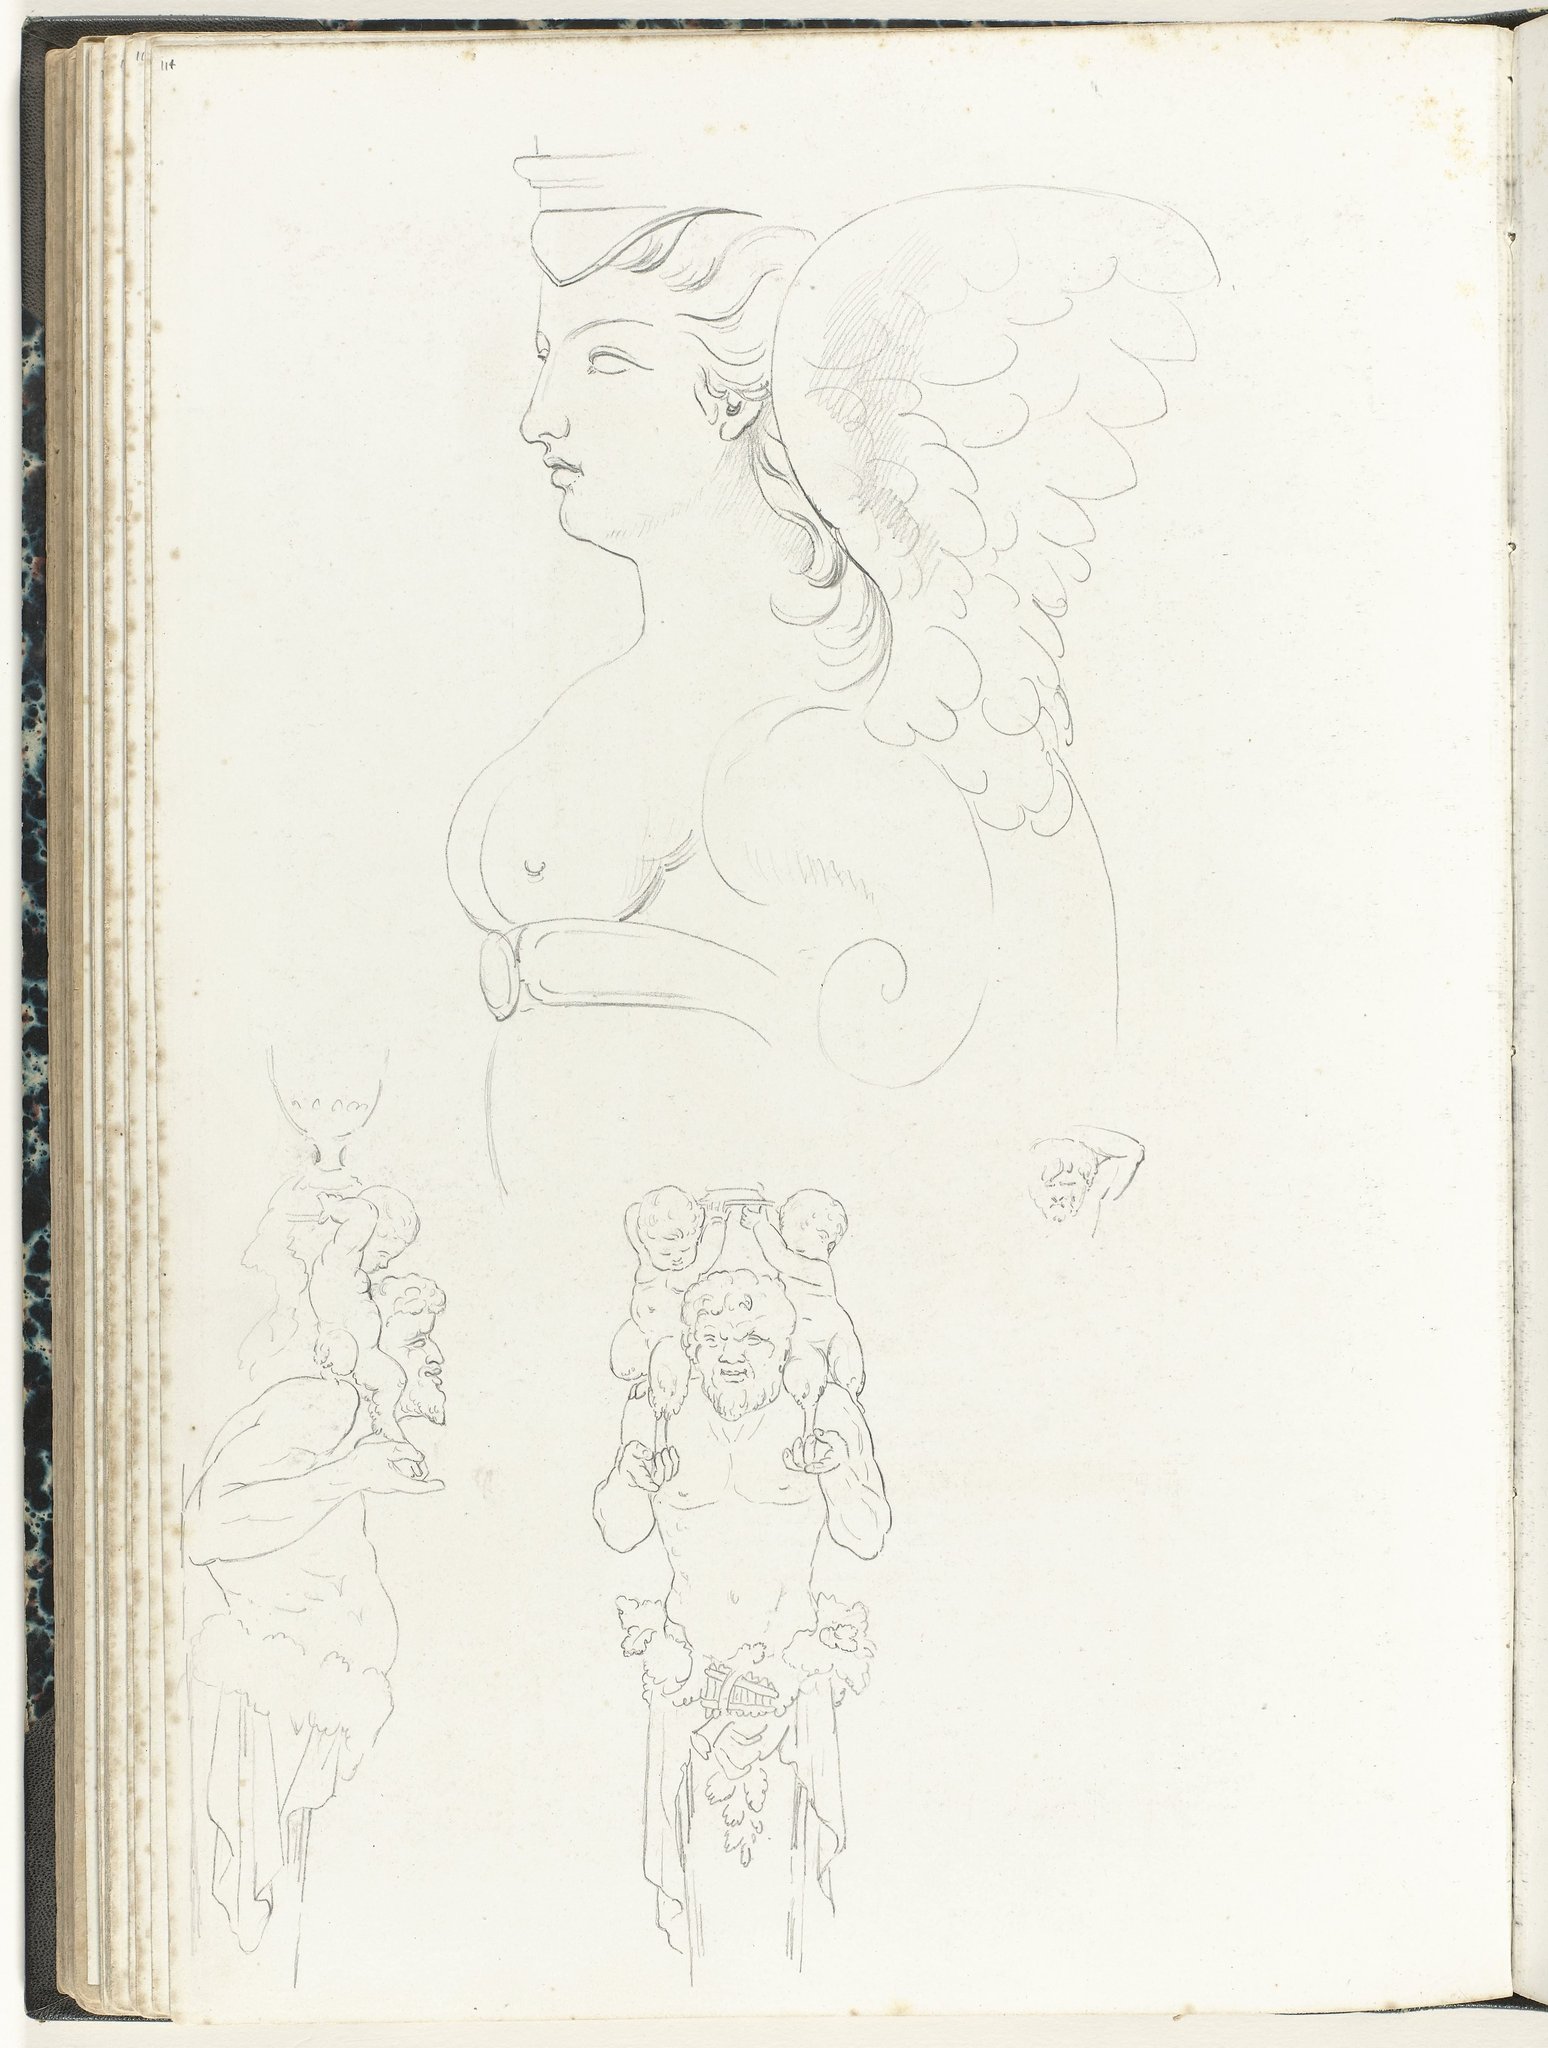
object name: drawing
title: Vrouwelijk bovenlichaam en mannelijke herme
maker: Anonymous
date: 1866-1900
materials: paper, pencil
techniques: drawing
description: Bovenaan bevindt zich het bovenlichaam van een gevleugelde vrouw, onderaan is een herme met twee saterkinderen op zijn schouders van voren en opzij afgebeeld.